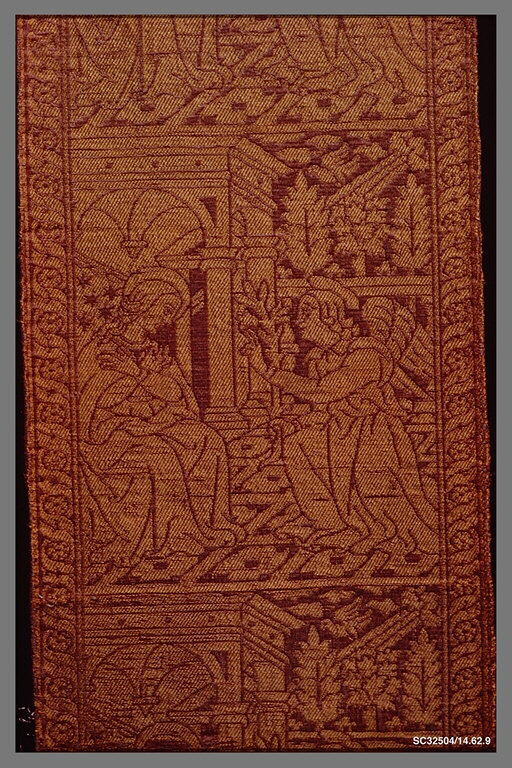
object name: orphrey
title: The Annunciation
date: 1500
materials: linen, silk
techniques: weave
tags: angels,virgin mary,annunciation